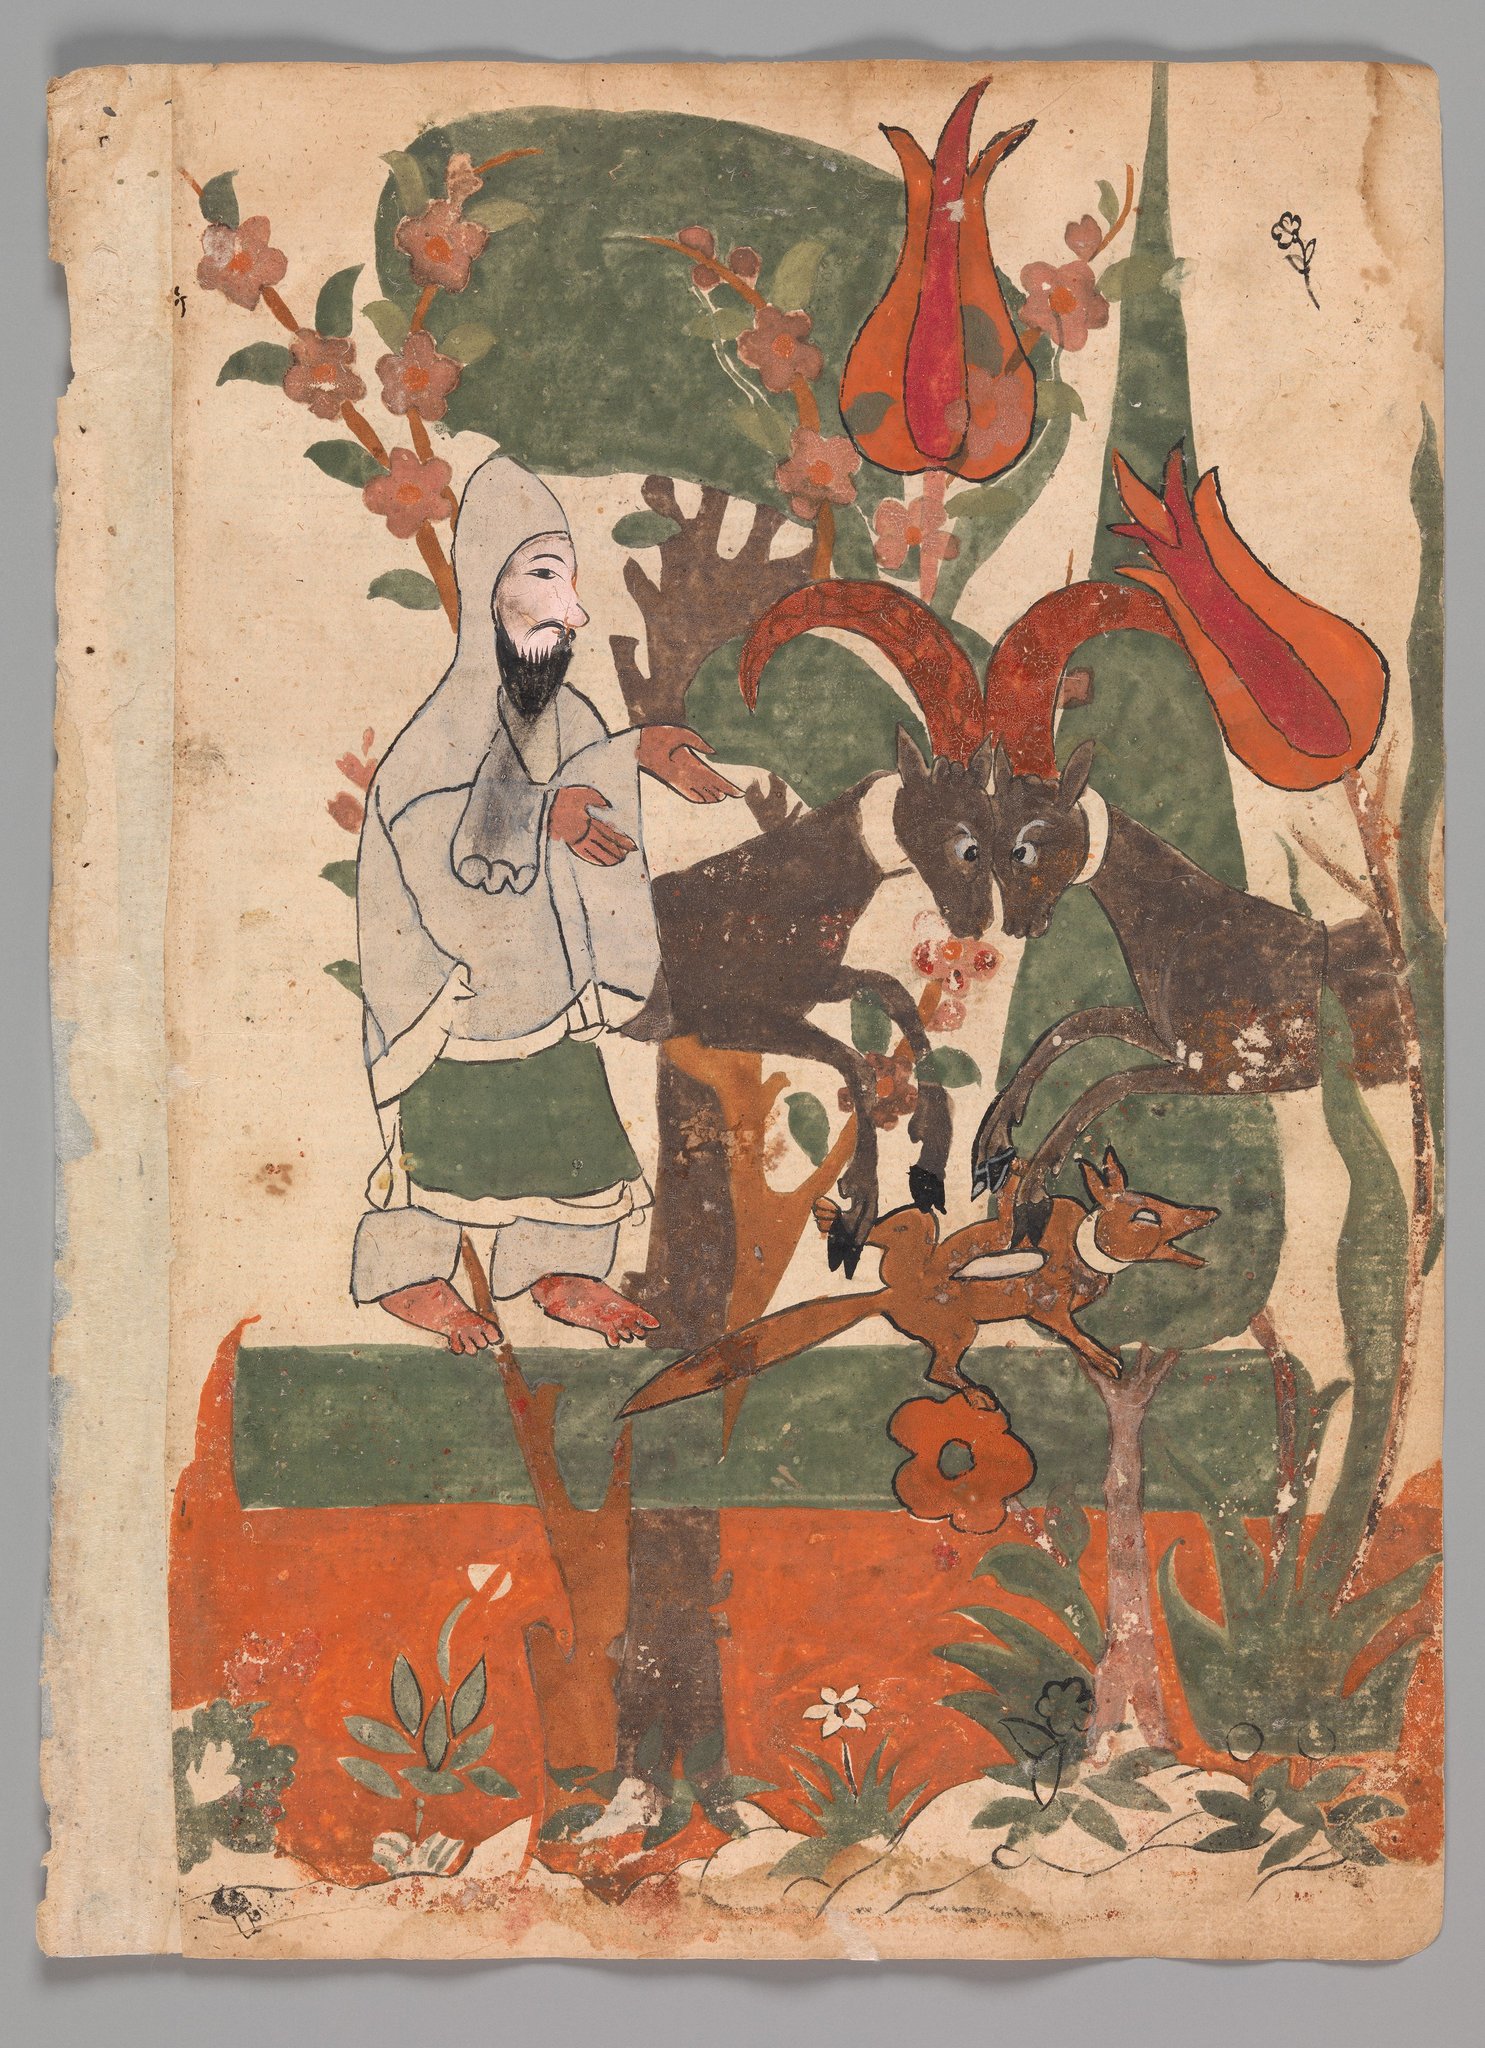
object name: folio from an illustrated manuscript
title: "The Fox and the Battling Rams Observed by the Ascetic", Folio from a Kalila wa Dimna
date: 1526-1550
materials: ink, paper, watercolor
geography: india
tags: men,foxes,rams